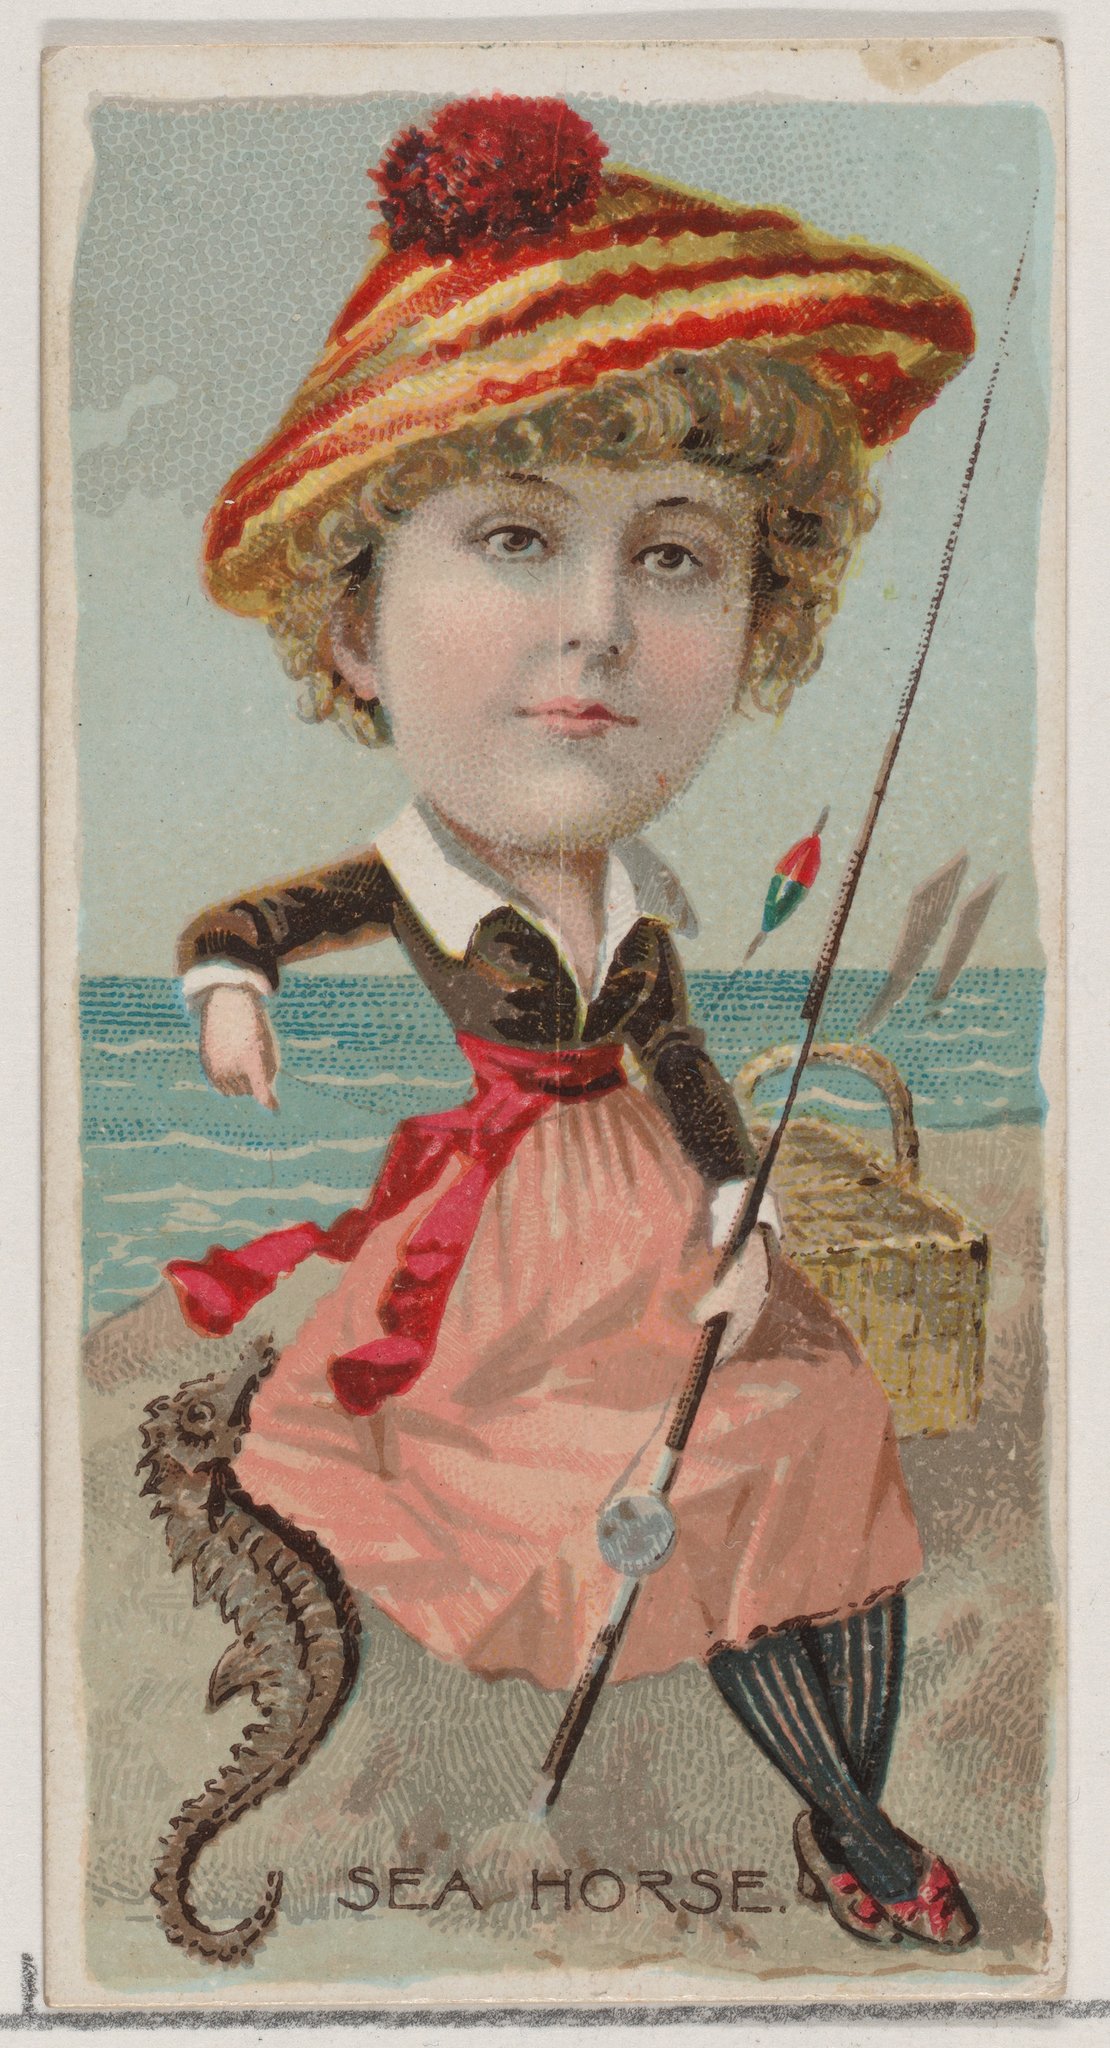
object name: print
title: Seahorse, from the series Fishers and Fish (N74) for Duke brand cigarettes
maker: knapp & company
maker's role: lithographer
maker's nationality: american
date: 1888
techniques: color lithograph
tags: women,fishing,fish